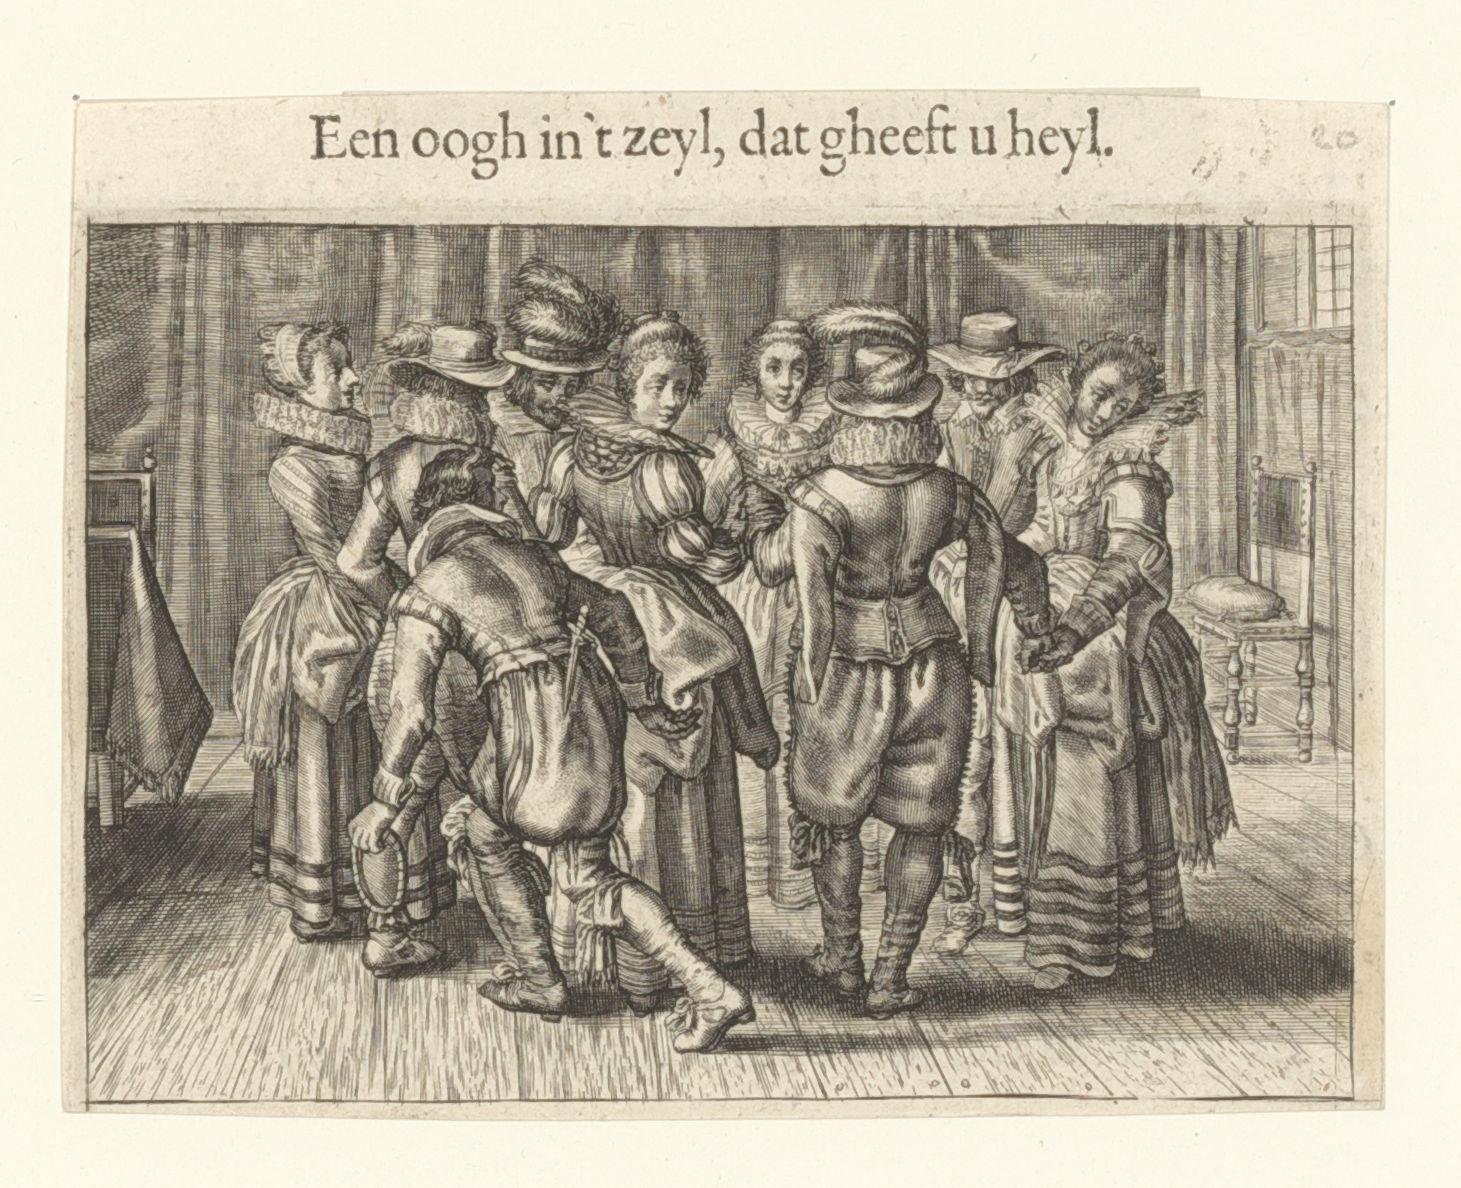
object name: book illustration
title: Een oogh in 't zeyl, dat gheeft u heyl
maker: Anonymous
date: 1624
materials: paper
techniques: engraving, letterpress printing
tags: adult woman, the course of life symbolized, adult man, running games played in a ring, proverbs, sayings, etc., grown-ups playing children's games, loose company, alertness, vigilance; 'guardia', 'vigilanza', 'vigilanza per difendersi & oppugnare altri' (ripa)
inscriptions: collector's mark: Lugt 1641, stamp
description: Twintigste embleem uit: Brune, Johan de. Zinne-werck, Voor-ghesyelt in Beelden, Ghedichten, ende breeder uyt-legginghen (...). Amsterdam: Evertsen Kloppenburch, 1624. Prent ook gebruikt in latere edities (1636 en 1661).